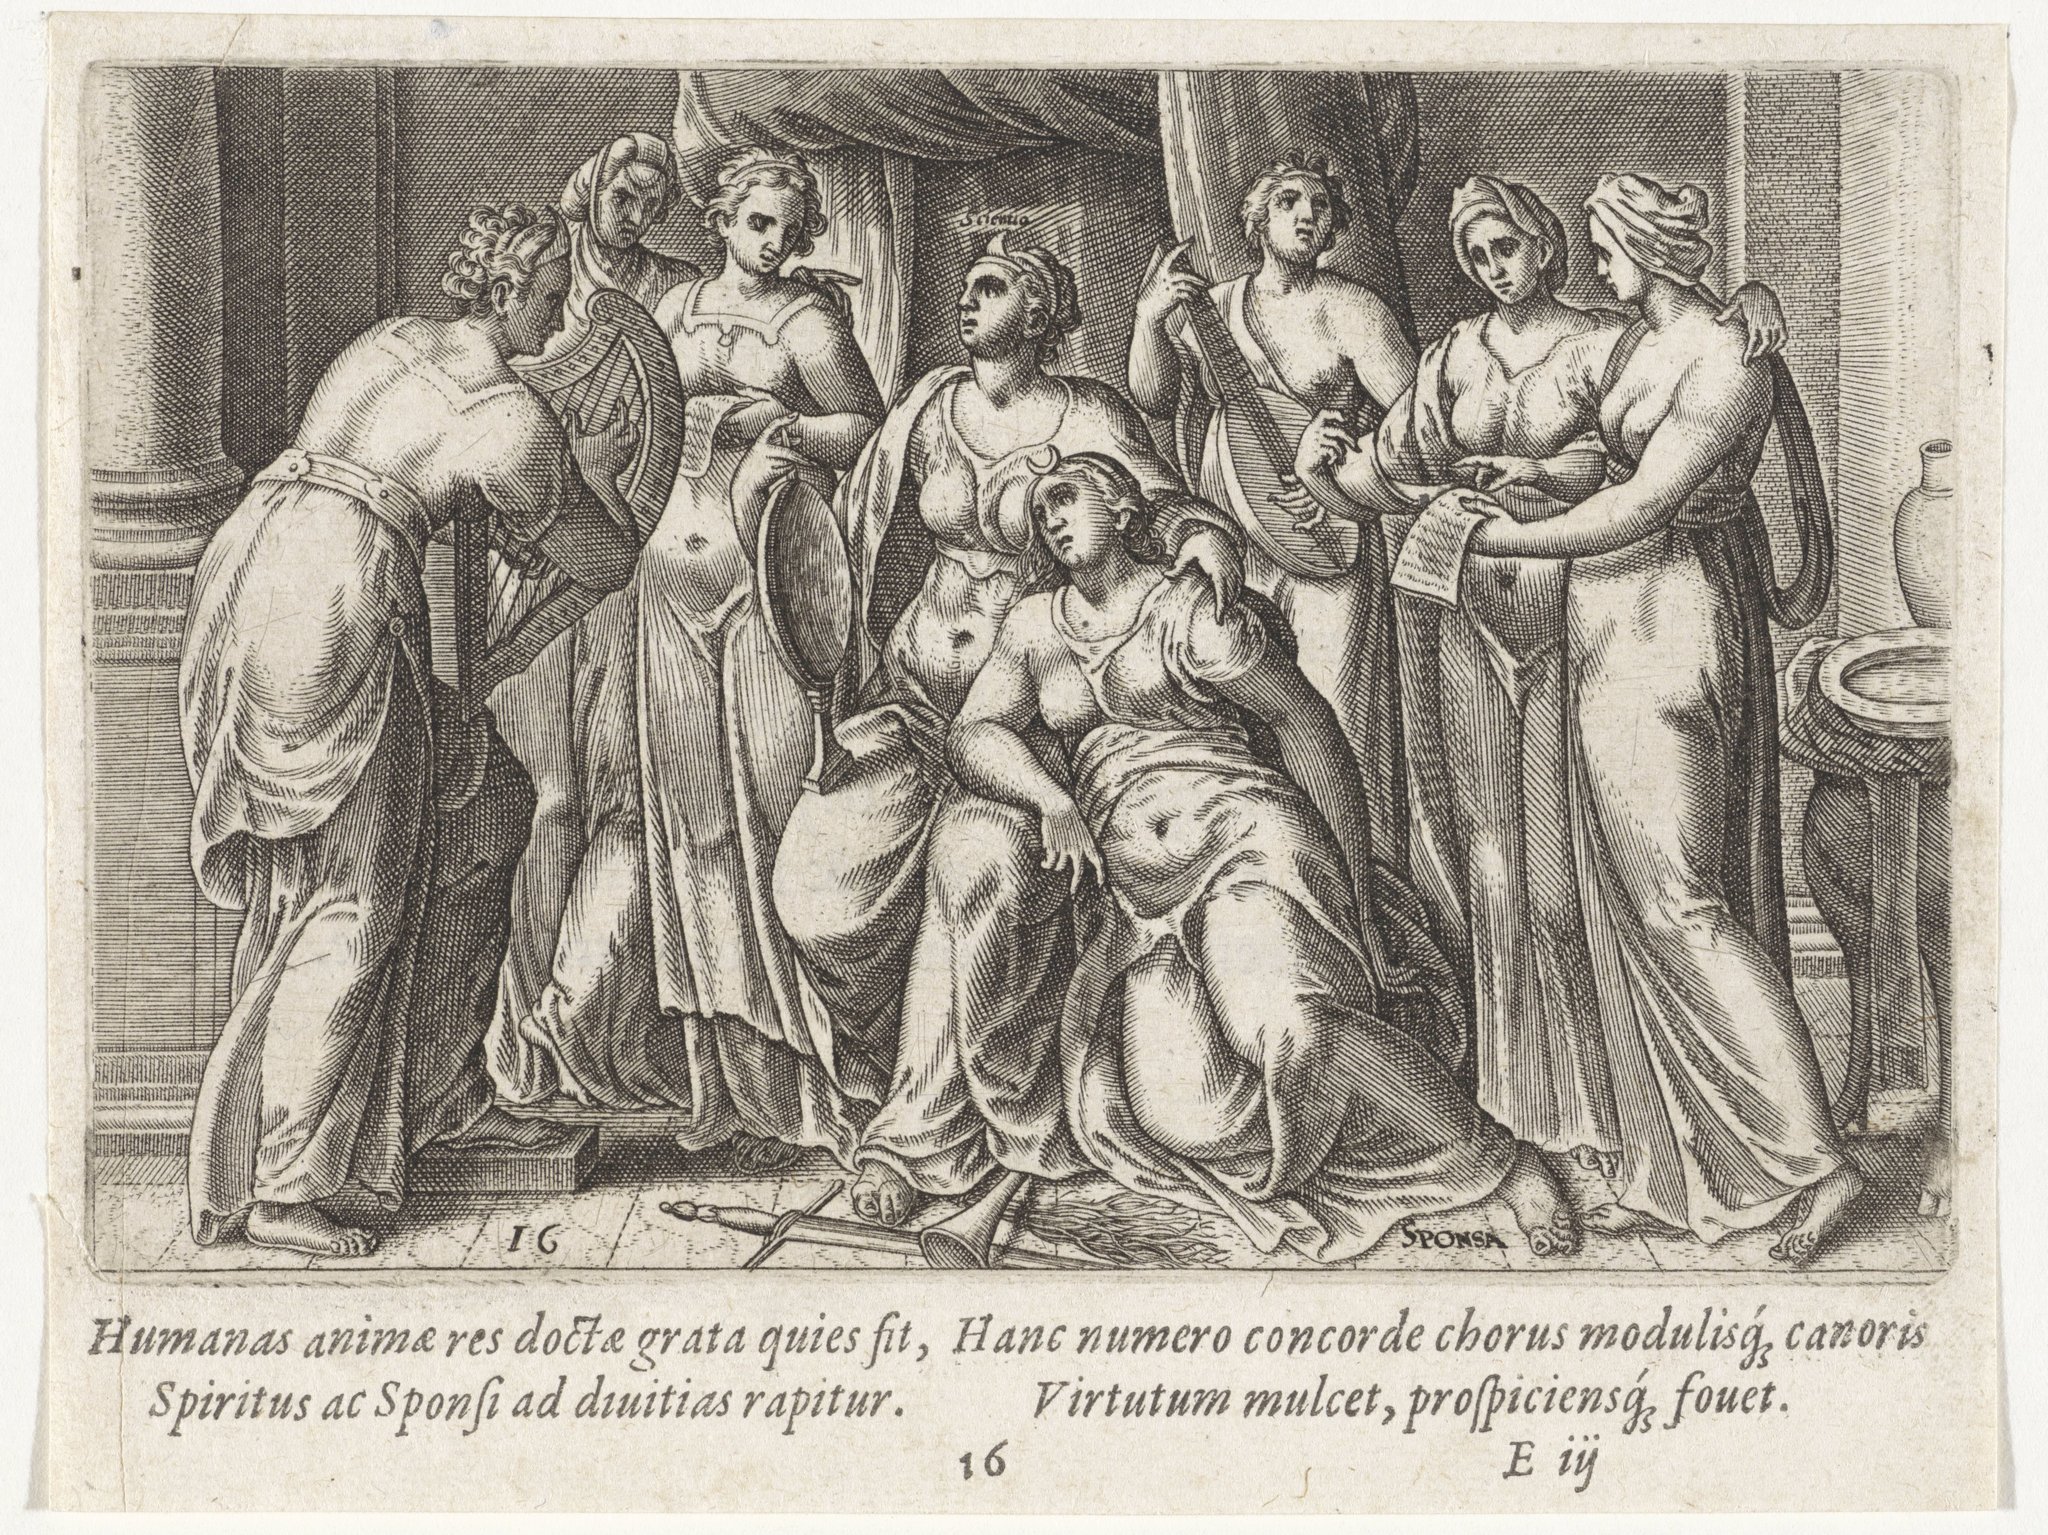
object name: print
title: De bruid te midden van musicerende maagden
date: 1574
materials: paper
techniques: engraving, letterpress printing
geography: antwerp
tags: making music; musician with instrument, symbolic representations, allegories and emblems ~ science, 'scientia'; 'scienza', 'studio' (ripa), virginity (+ variant), bride (in wedding-dress)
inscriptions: collector's mark: Lugt 2228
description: De bruid (Sponsa) wordt omarmd door Wetenschap (Scientia). Ze worden omringd door musicerende maagden. In de marge een vierregelig onderschrift, in twee kolommen, in het Latijn.